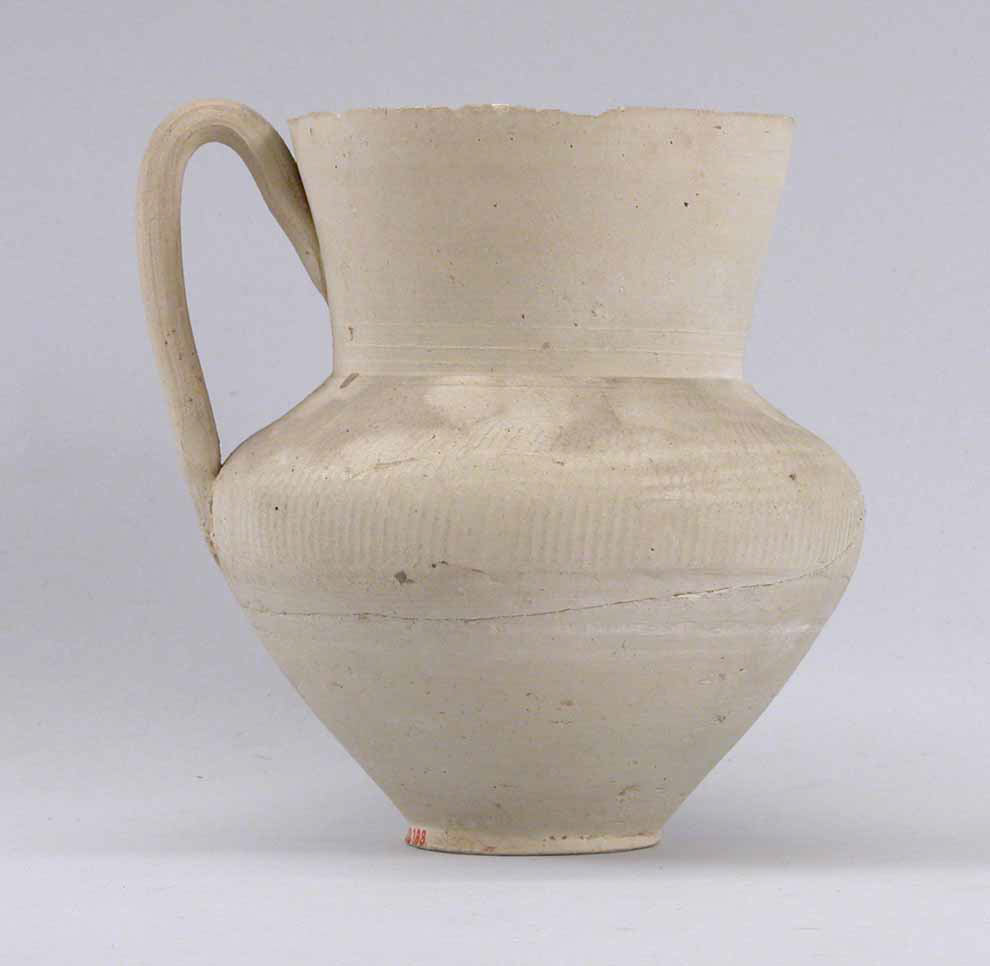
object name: ewer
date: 801-1000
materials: earthenware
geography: iran